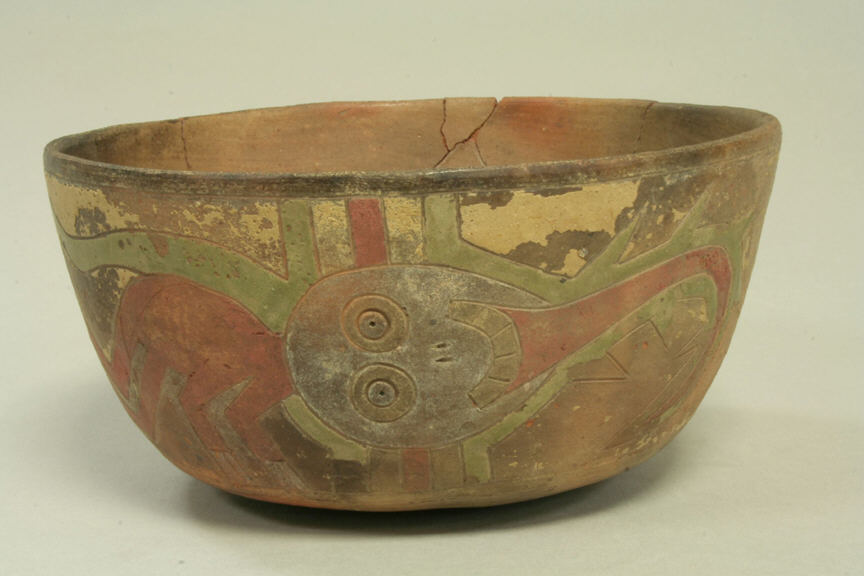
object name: bowl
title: Painted Bowl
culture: paracas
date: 600-301 BCE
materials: ceramic, pigment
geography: peru